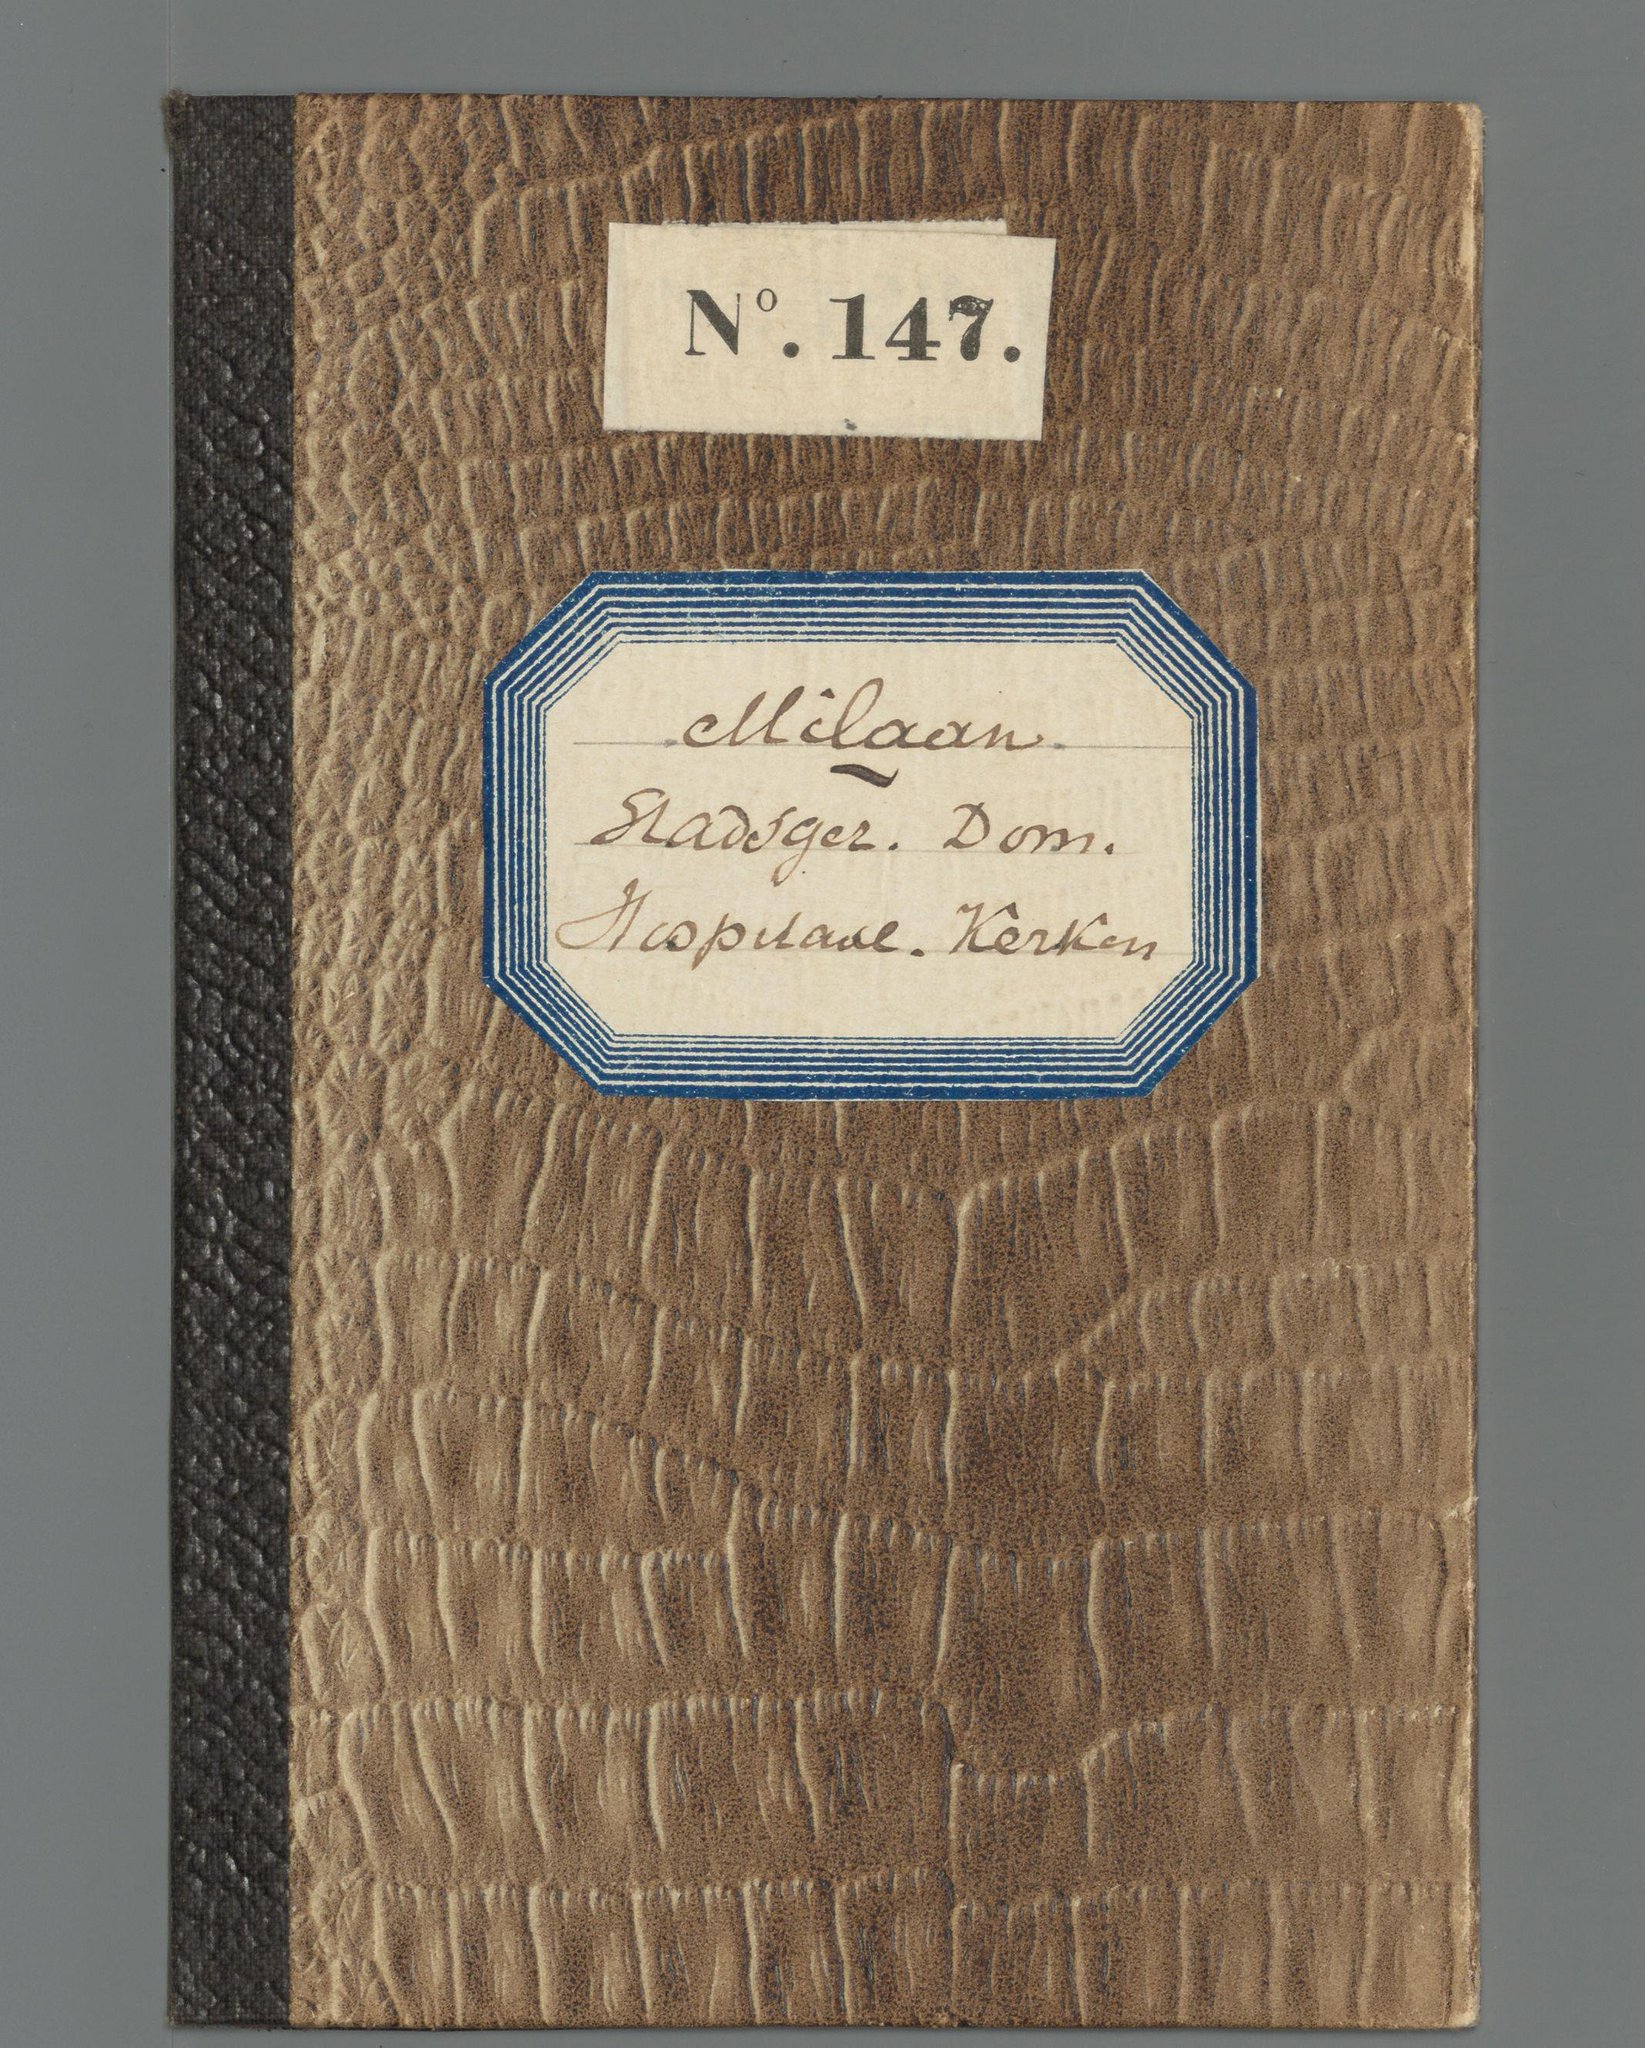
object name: wrapper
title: Omslag voor twintig prentbriefkaarten van Milaan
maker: Anonymous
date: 1900-1950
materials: cardboard, ink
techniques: pen